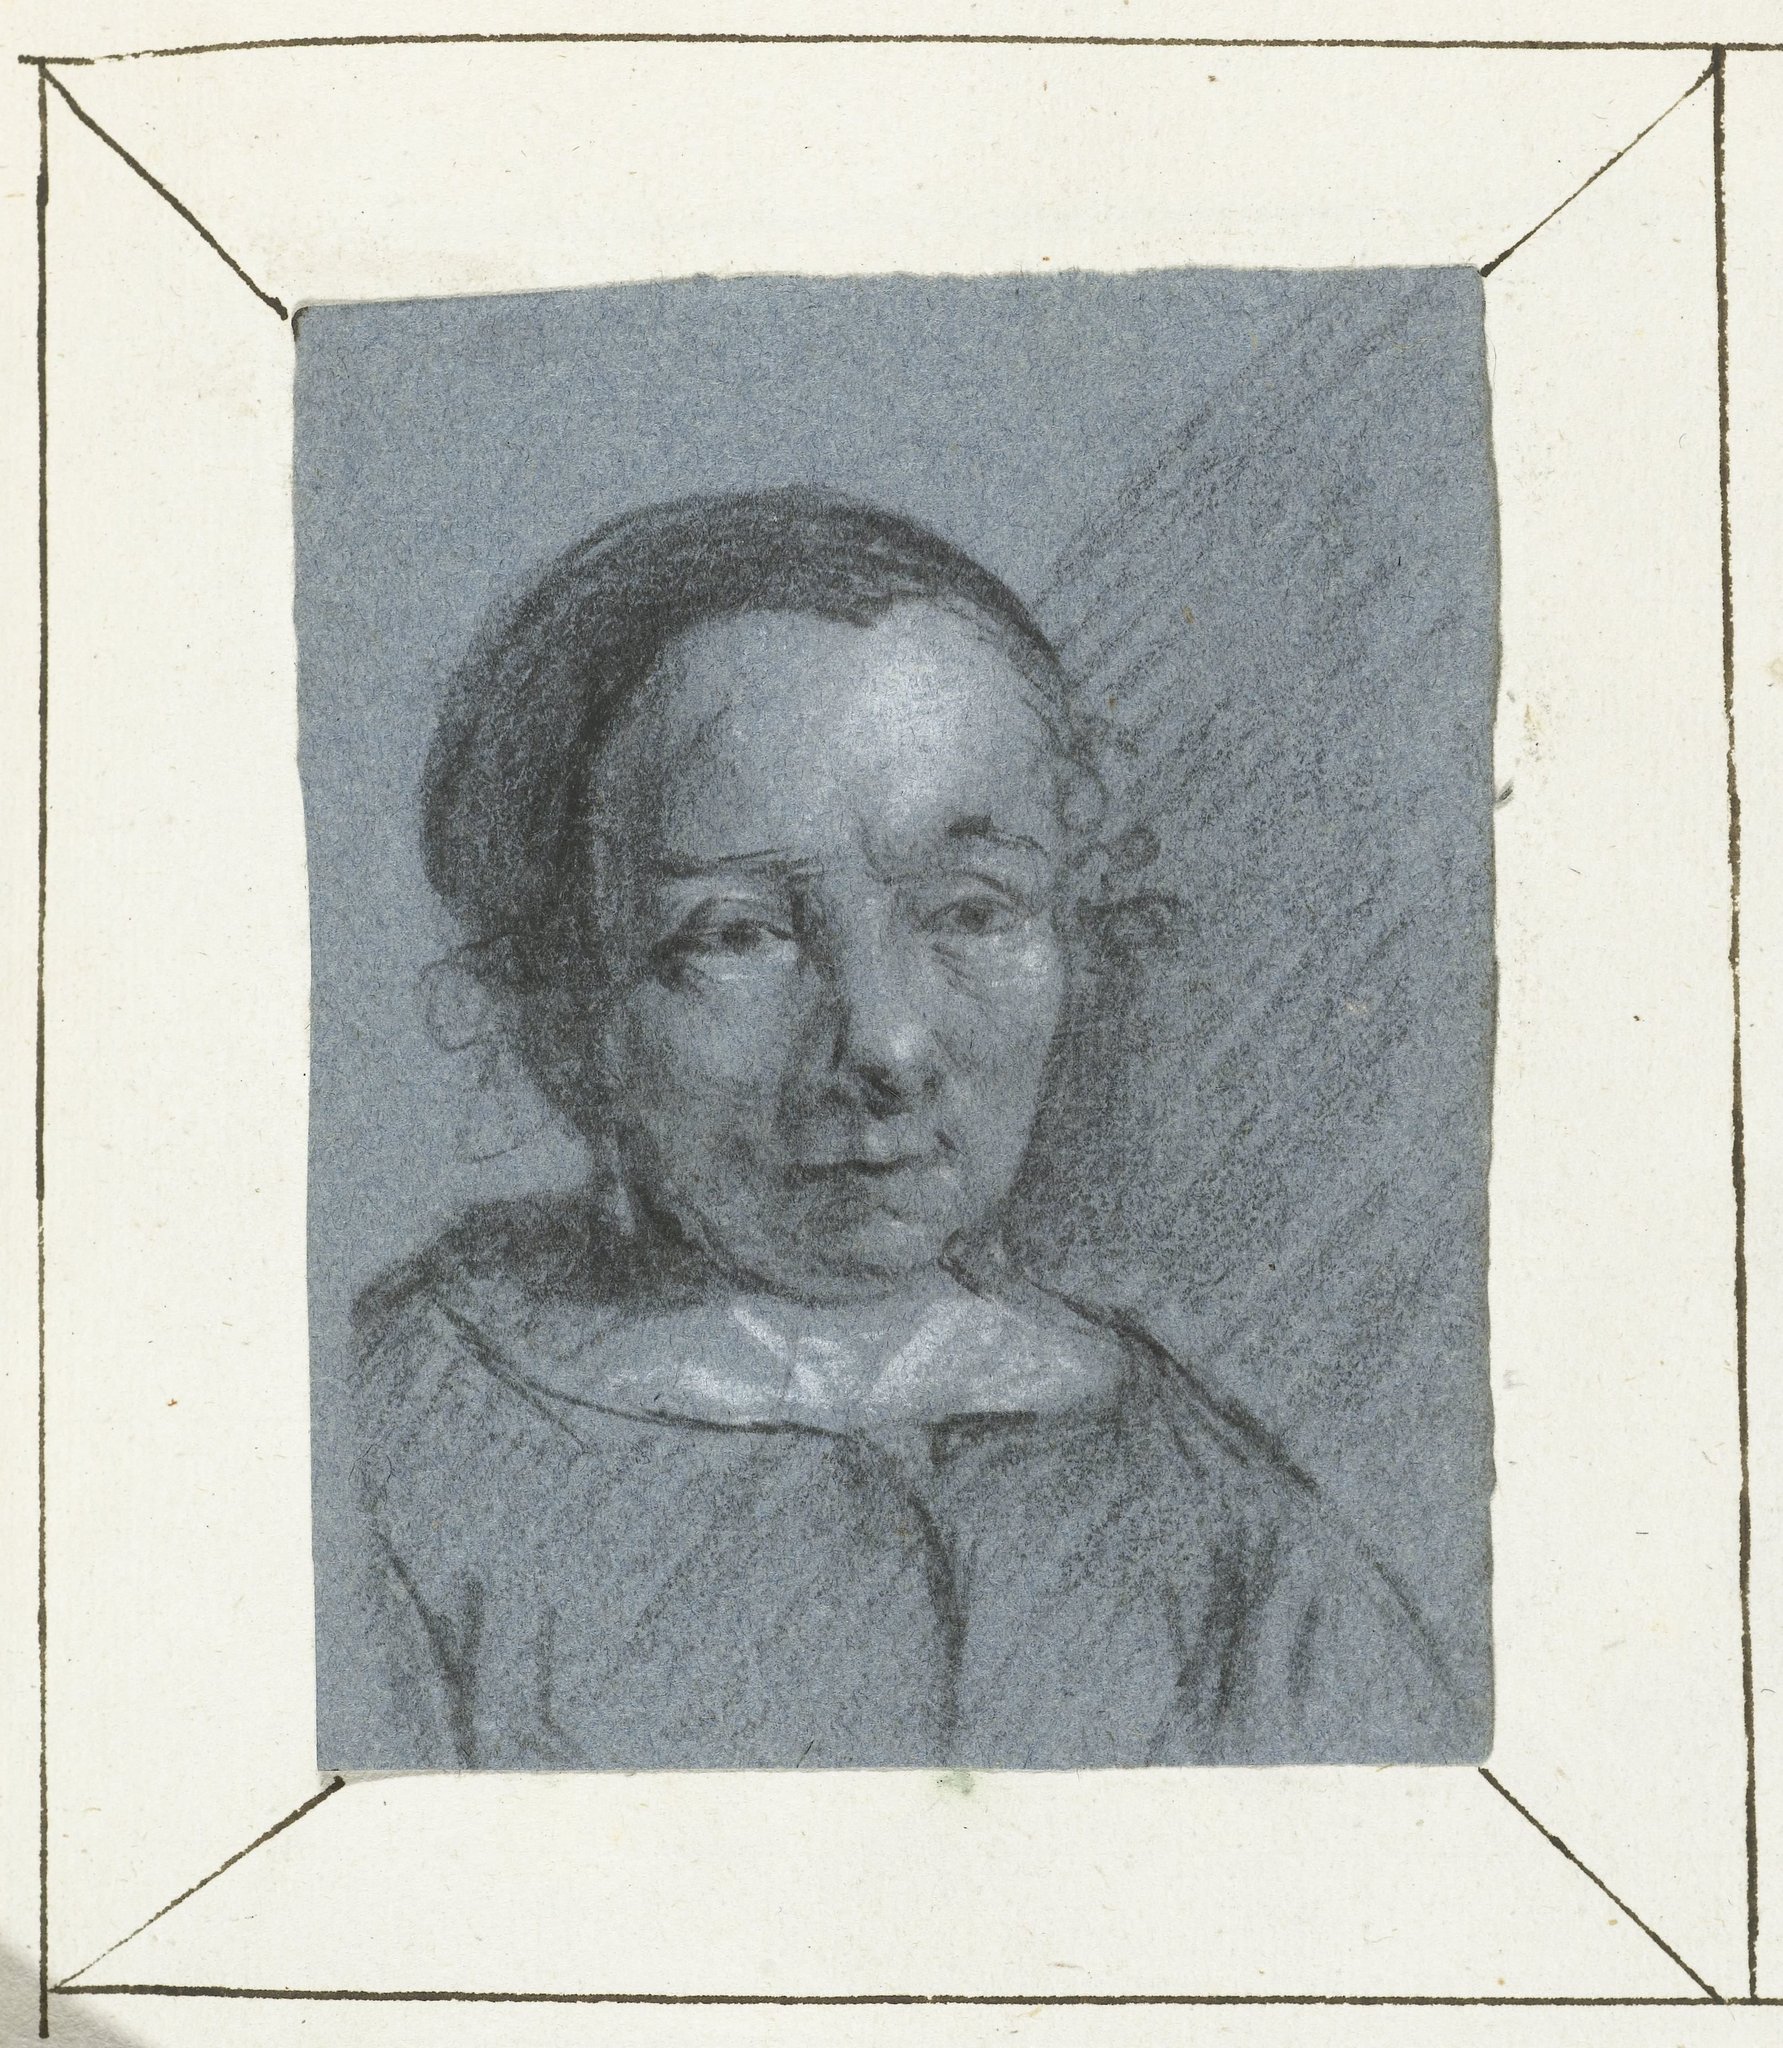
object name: drawing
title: Studie van een vrouwenhoofd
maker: moses ter borch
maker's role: draughtsman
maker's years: 1645-1667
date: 1660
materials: chalk, paper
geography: zwolle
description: Tekening met twee andere tekeningen op een blad geplakt in het Plakboek. De vrouw staat ook op twee andere losse tekeningen van Moses (zie catalogusnummers M 58 en M 59).